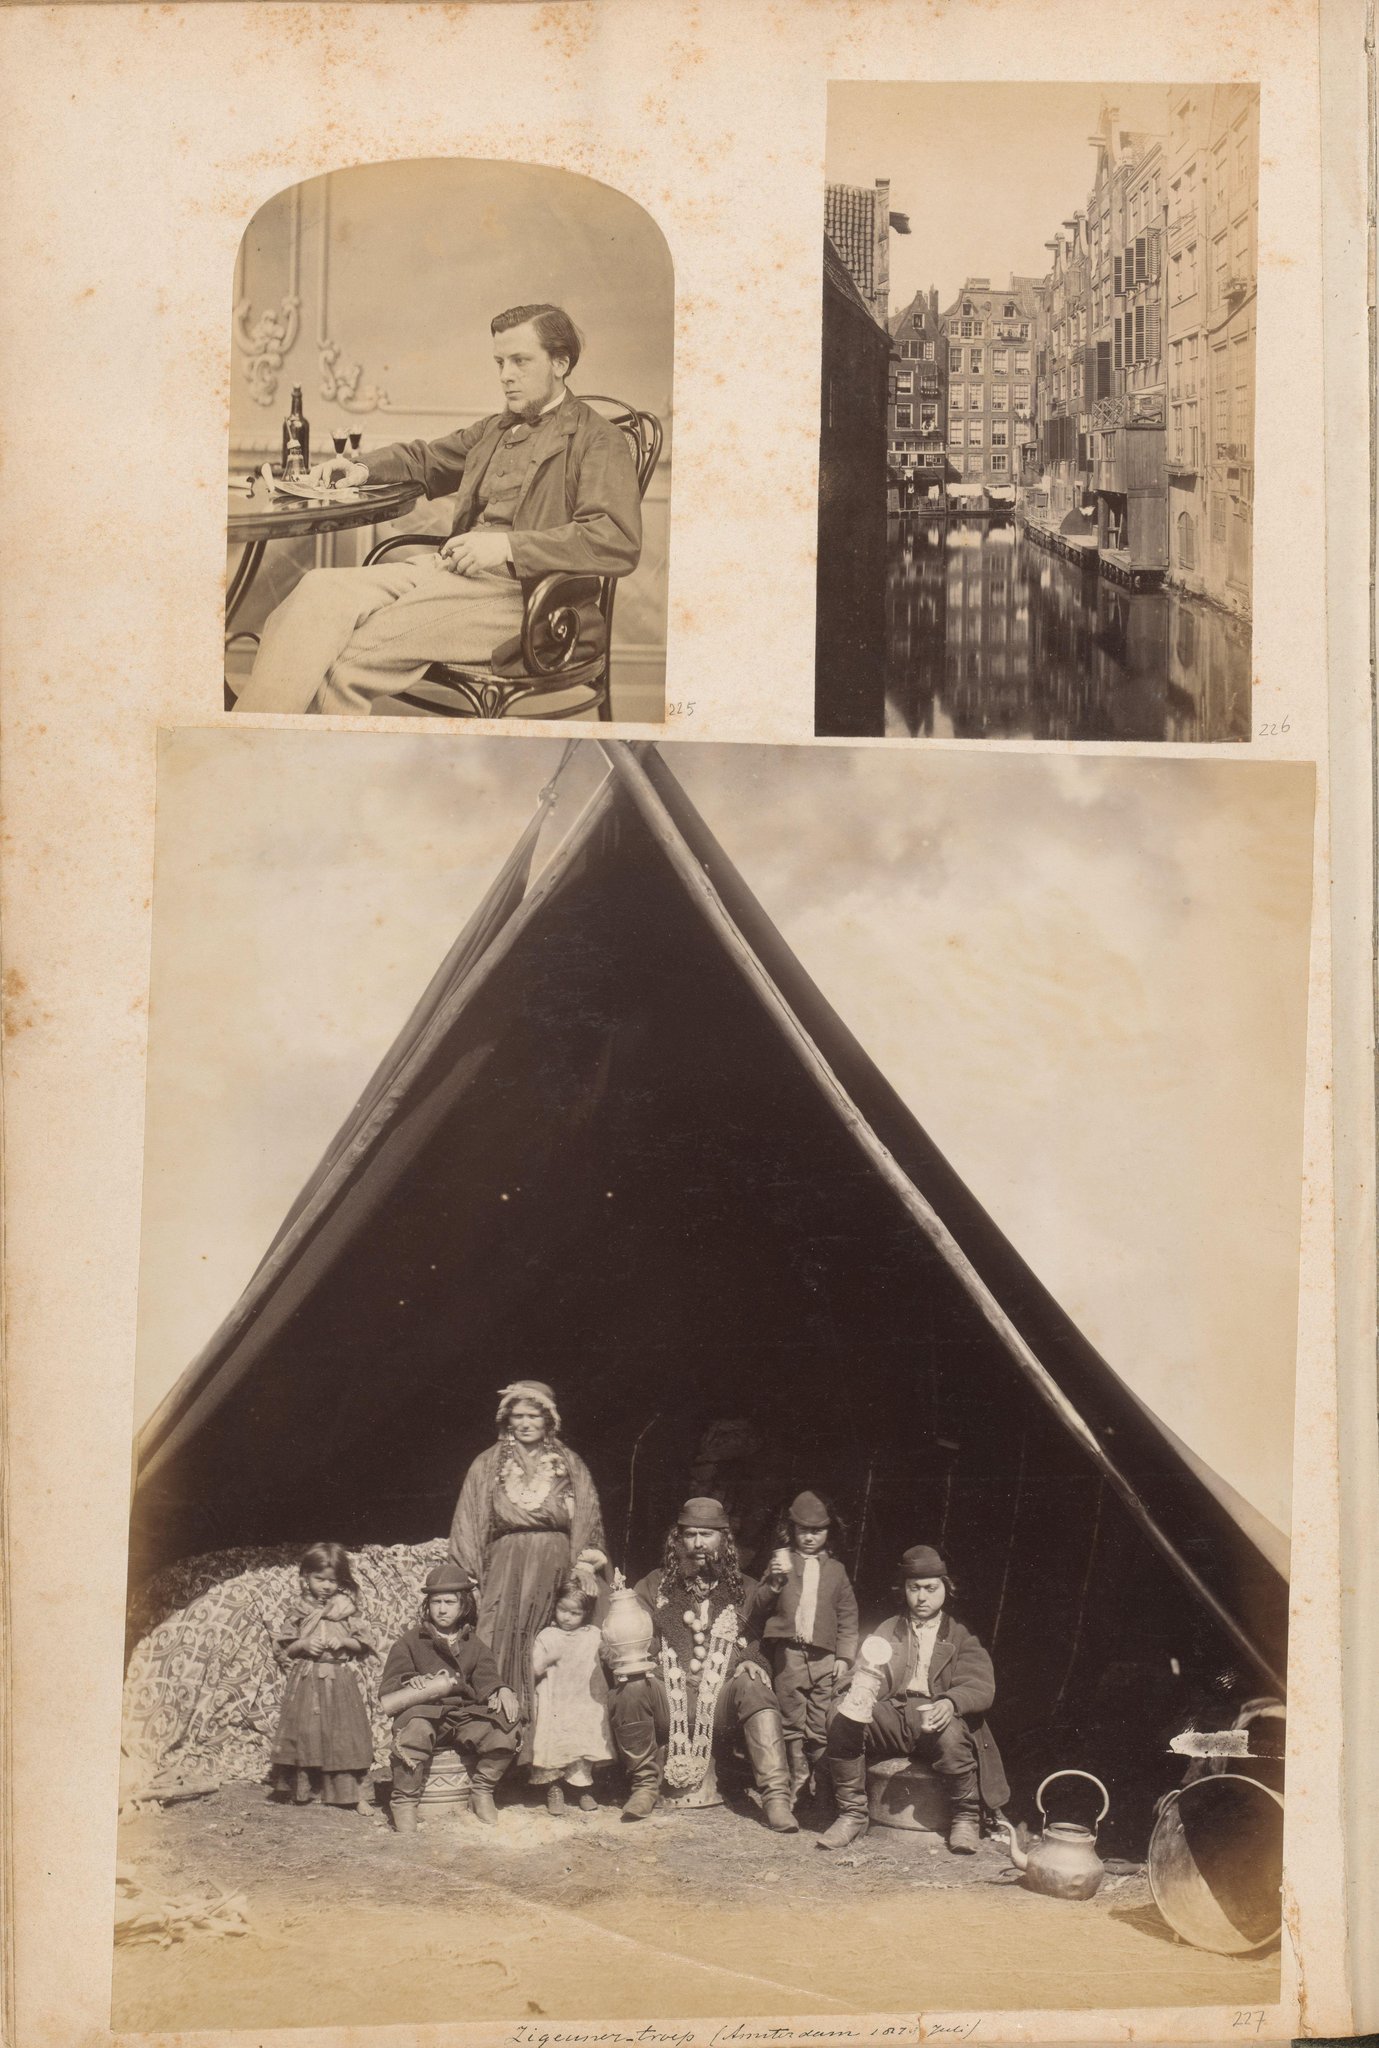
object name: album leaf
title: Portret van Claude August Crommelin (1840-1874), zittend naast een tafel met glazen en fles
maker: Anonymous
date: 1865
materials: paper, photographic support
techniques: albumen print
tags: claude august crommelin (1840-1874), adult man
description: Onderdeel van Fotoalbum van Robert Daniel Crommelin (1841-1907).